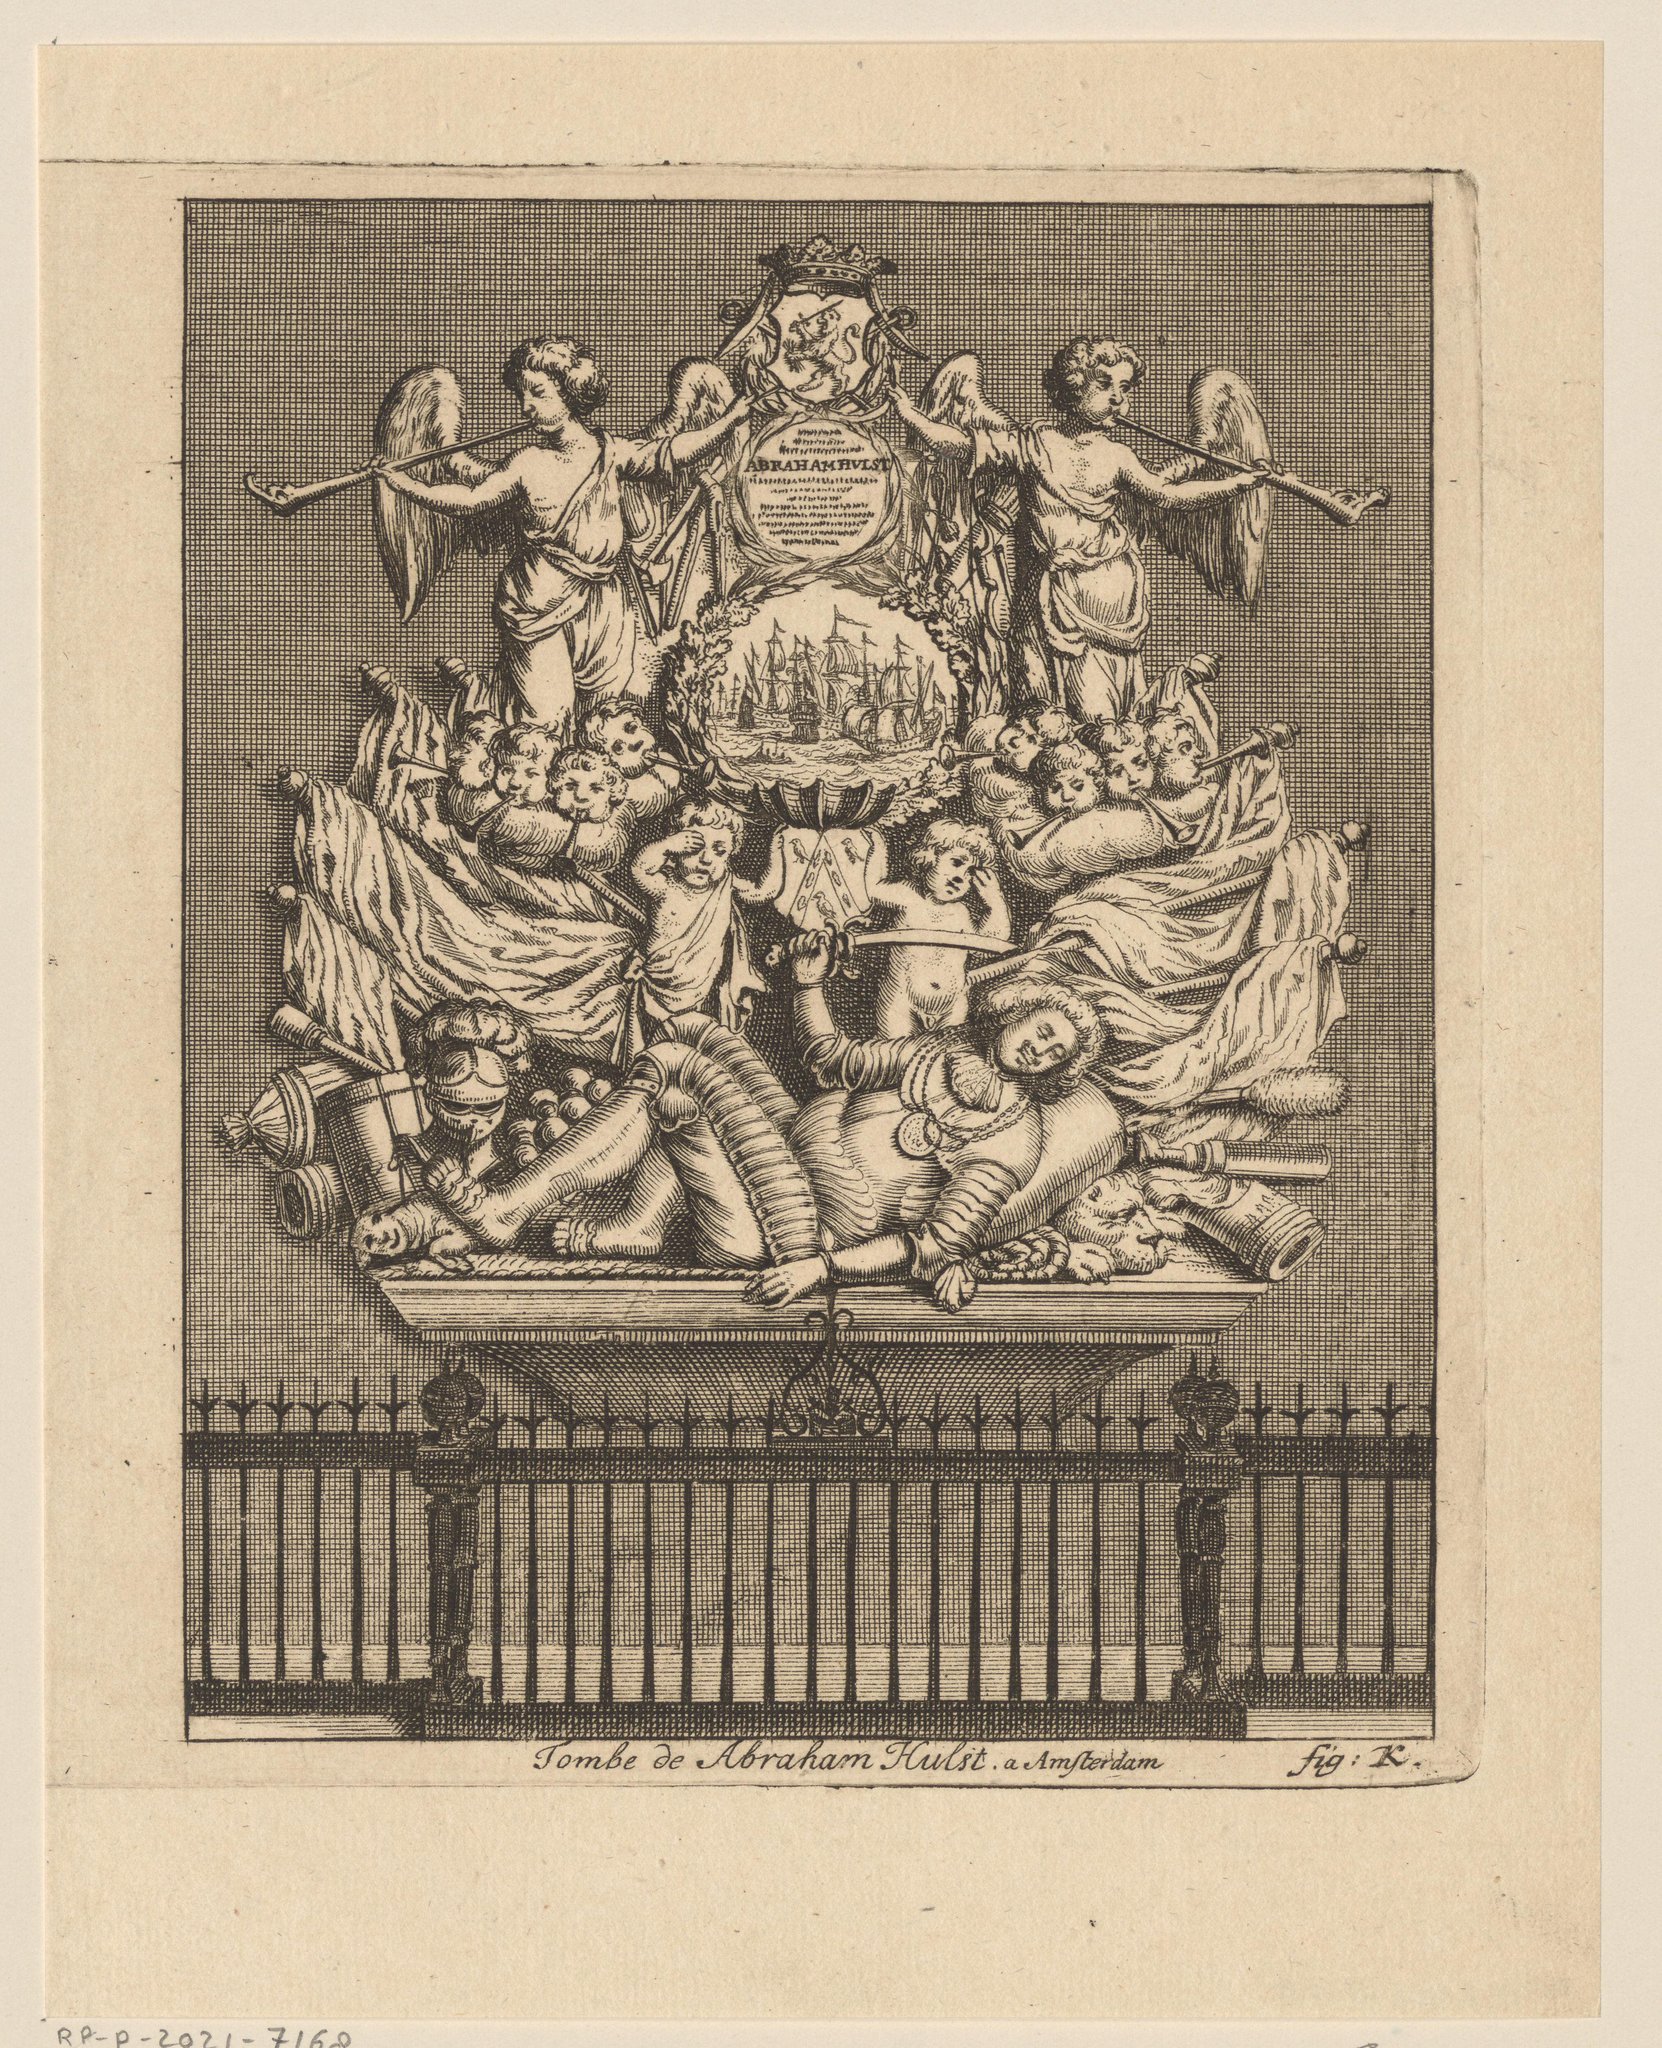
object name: print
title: Grafmonument van Abraham van der Hulst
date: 1690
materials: paper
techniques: engraving, etching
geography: amsterdam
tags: amsterdam, battle (+ naval force), grave, tomb and other grave-forms and grave-markers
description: Prent uit: Bizot, Pierre. Supplement a l'histoire metallique de la republique de Hollande. Amsterdam: Pieter Mortier (I), 1690. Prent ook gebruikt in de Nederlandse editie van dit werk, uitgegeven in hetzelfde jaar bij dezelfde uitgever.